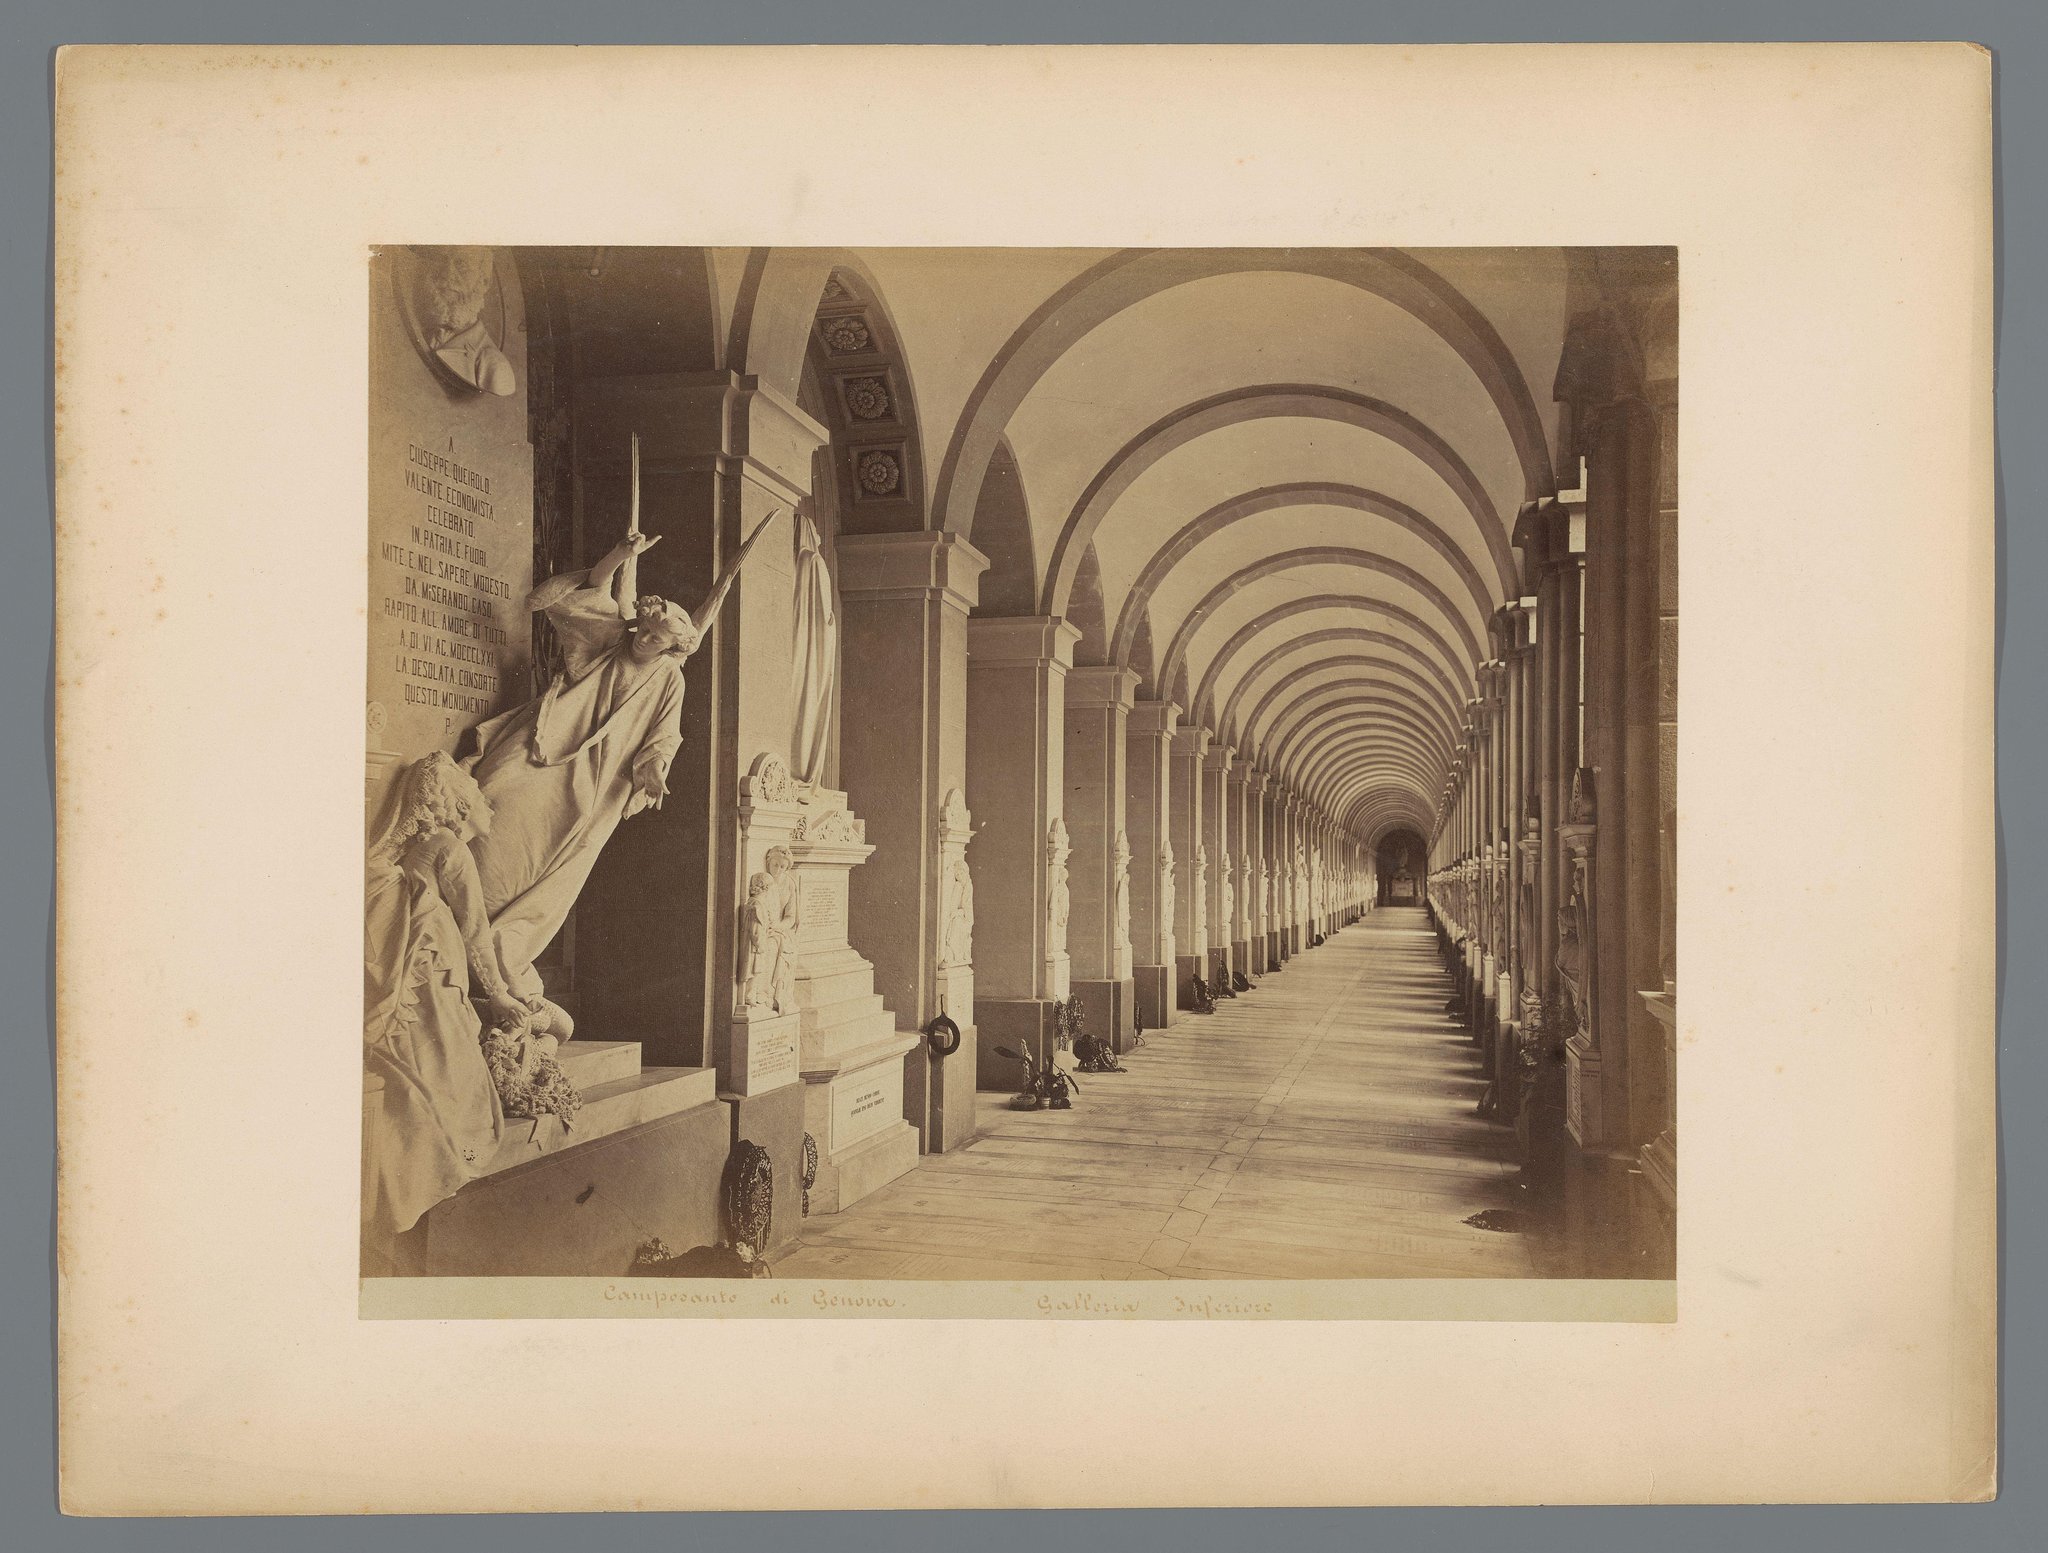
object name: photograph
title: Kremlin's voice flies here attends British peace committee conference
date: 1950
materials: photographic support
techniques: gelatin silver print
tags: london